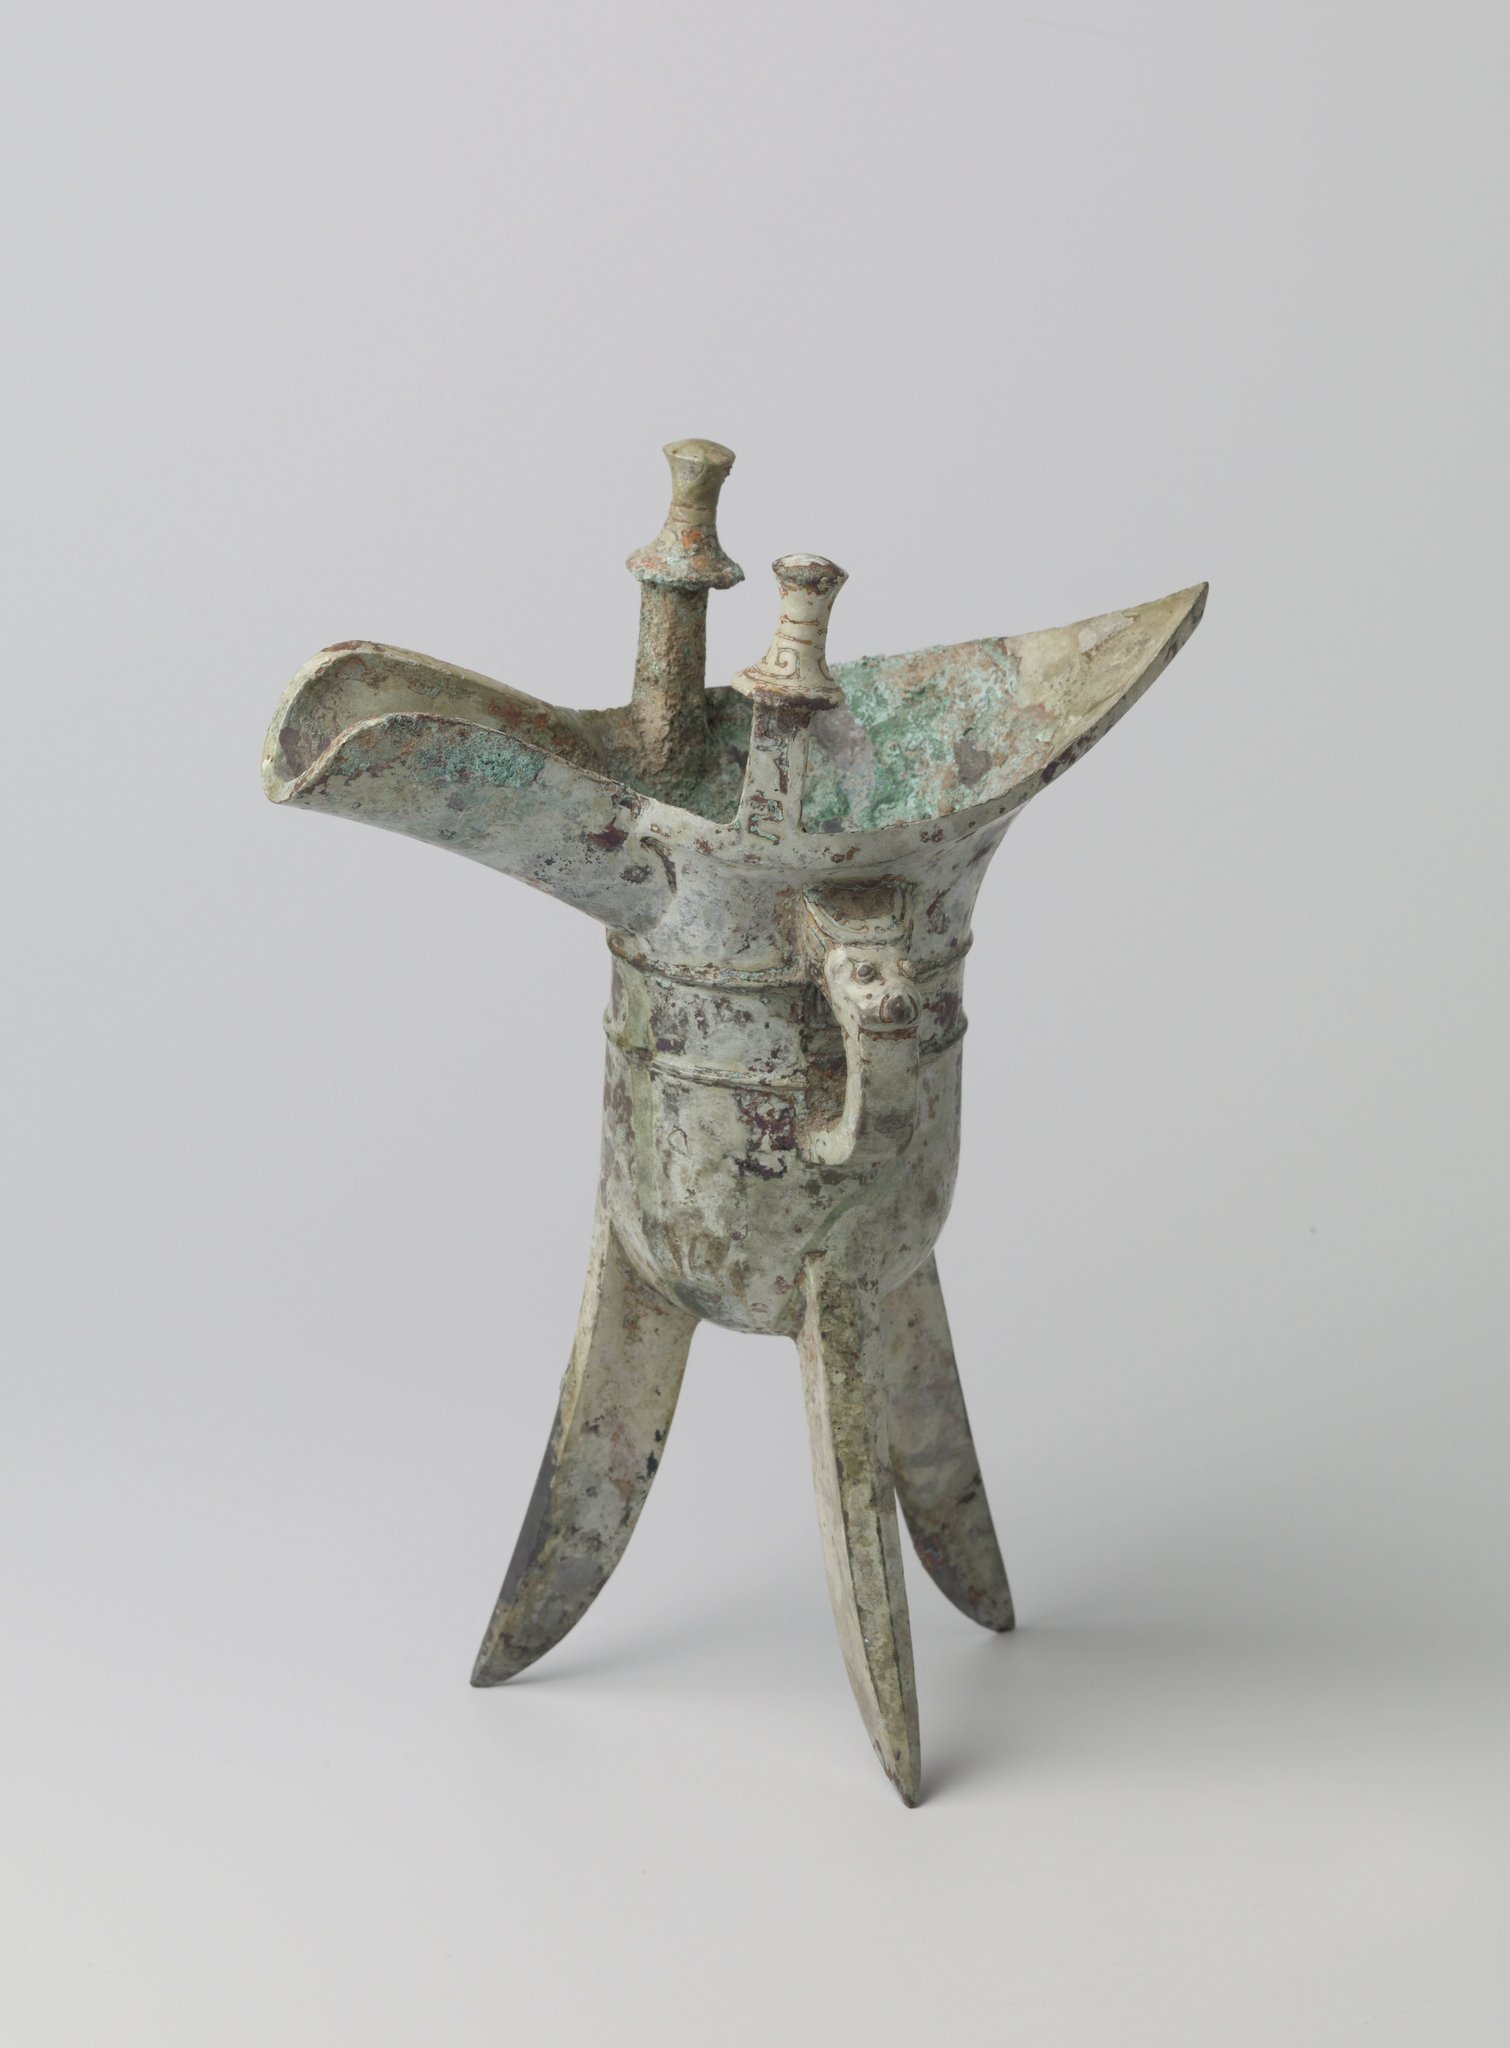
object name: religious ritual object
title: Ritual libation vessel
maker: Anonymous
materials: bronze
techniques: casting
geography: china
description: Beker op drievoet, met een uitkragende rand en een grote schenktuit. Twee oren en twee opstaande knoppen aan de rand.